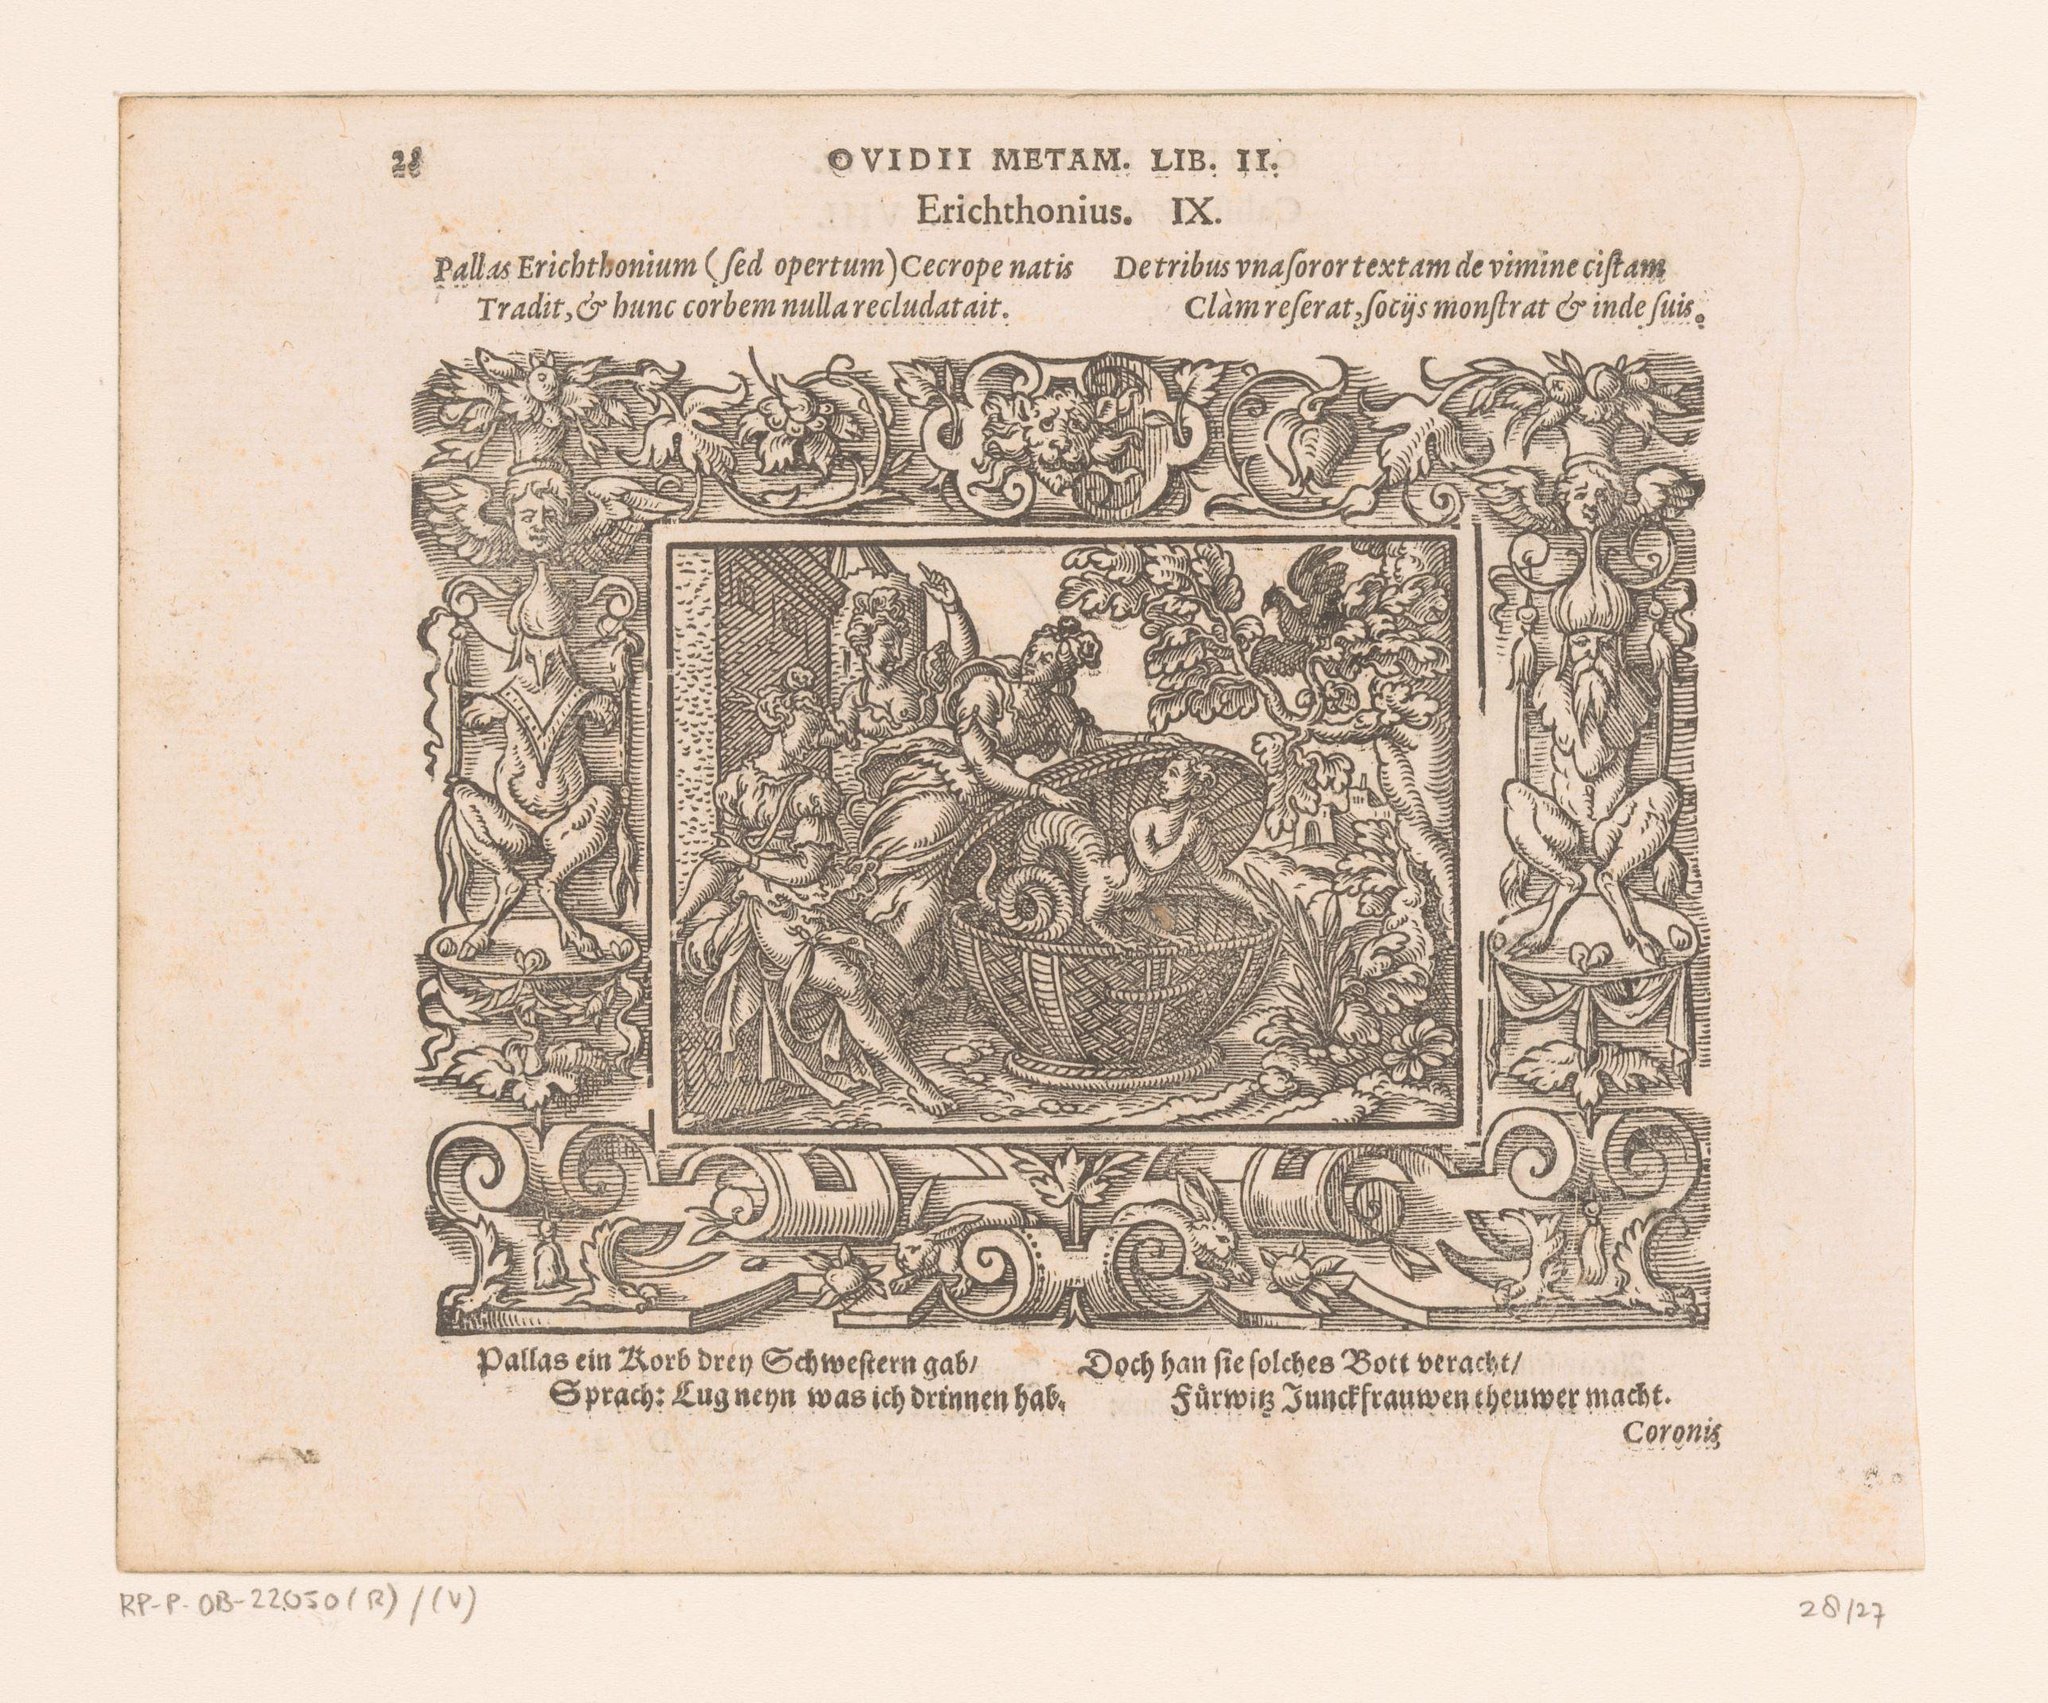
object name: book illustration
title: Dochters van Cecrops openen de mand van Minerva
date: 1569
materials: paper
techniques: letterpress printing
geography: frankfurt am main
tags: scrollwork, strapwork ~ ornament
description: Illustratie bij de Metamorfosen van Ovidius, afkomstig uit de publicatie: Posthius, Johannes. Tetrasticha in Ovidii metam. Frankfurt am Main: Georg Rab en Sigmund Feyerabend en erven Weigand Han, 1569. De voorstellingen en ornamentranden van deze boekillustraties zijn van twee aparte blokken gedrukt. Beide werden afzonderlijk van elkaar ook gebruikt voor andere publicaties, en de ornamentranden werden eveneens binnen deze publicatie meerdere keren gebruikt.